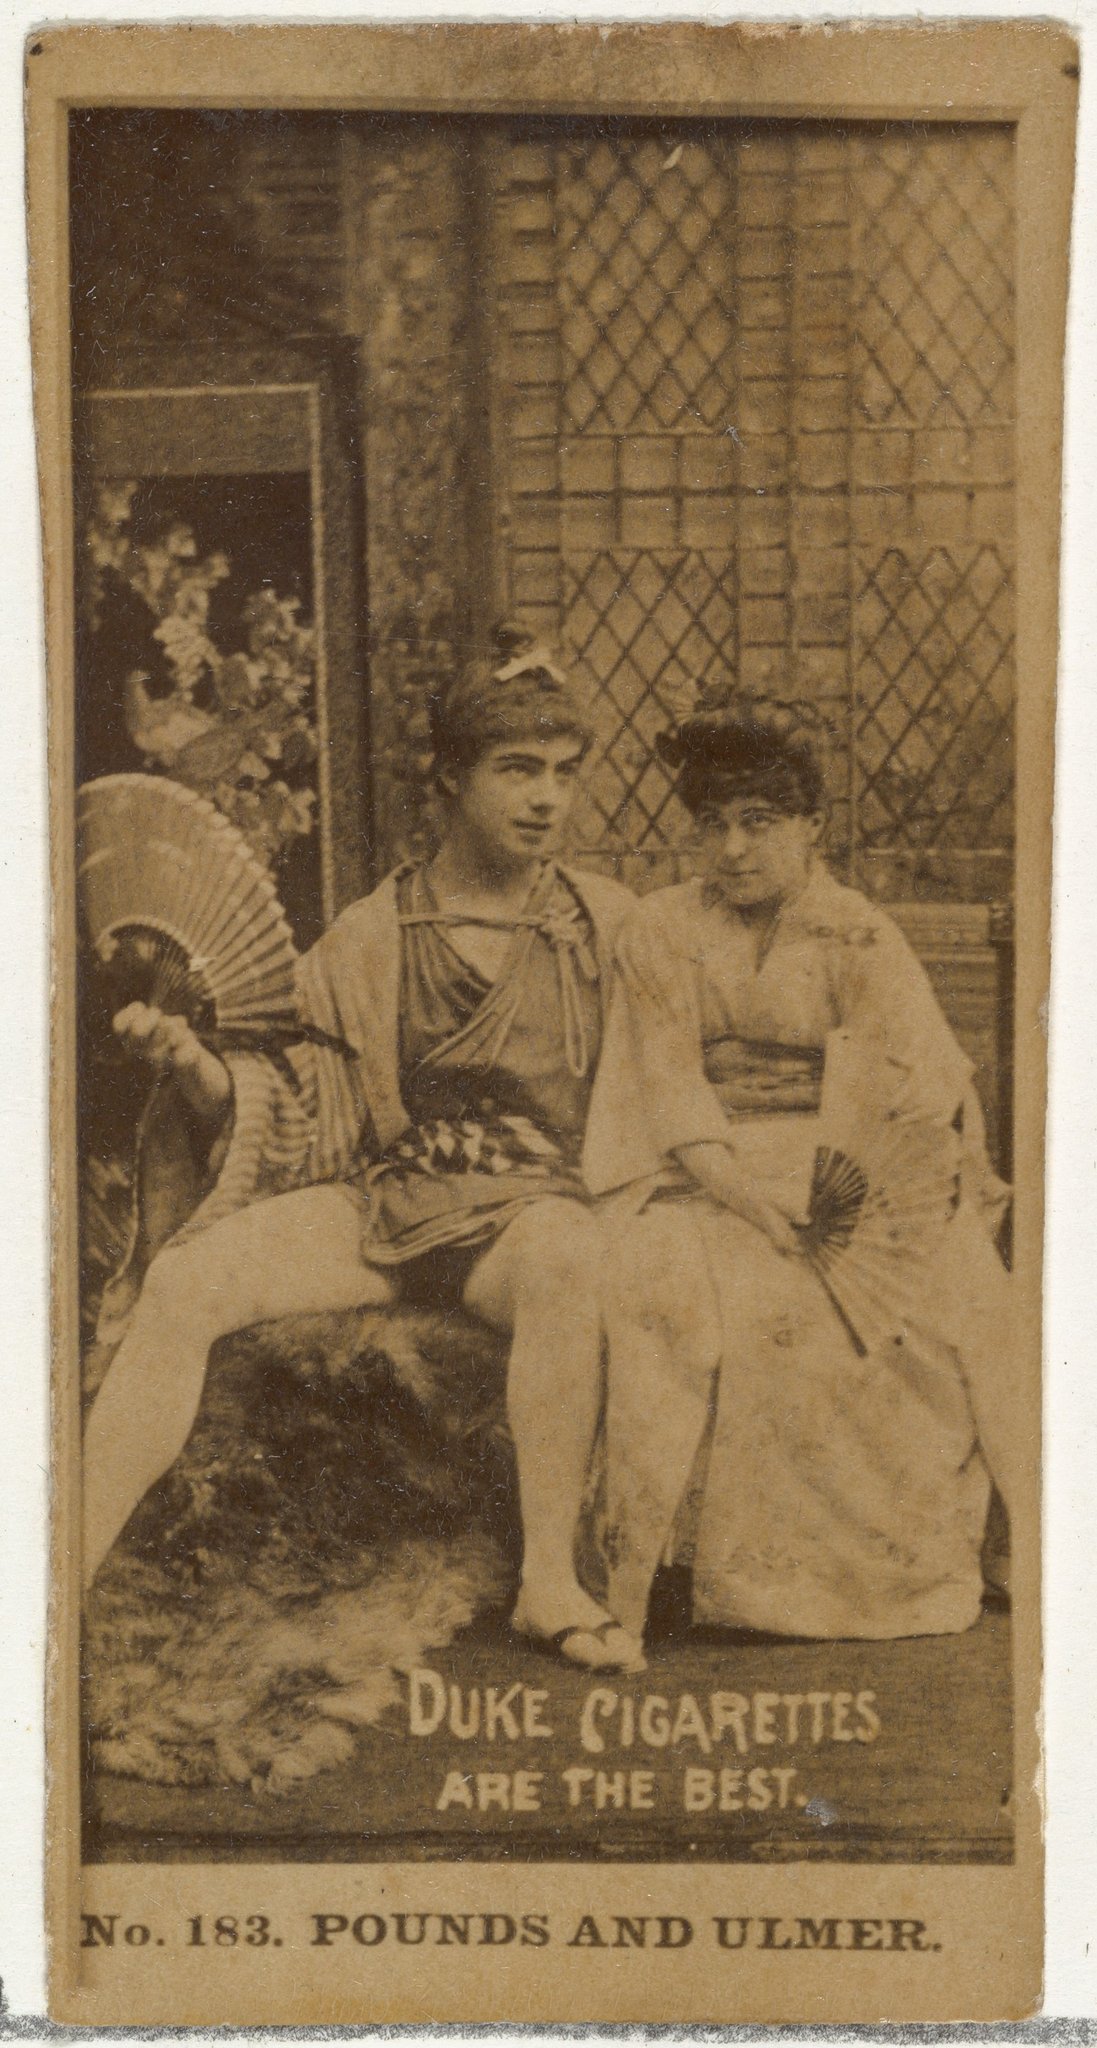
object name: photograph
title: Card Number 183, Pounds and Ulmer, from the Actors and Actresses series (N145-6) issued by Duke Sons & Co. to promote Duke Cigarettes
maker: w. duke, sons & co.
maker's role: publisher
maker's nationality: american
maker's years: 1870-1920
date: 1880-1889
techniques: albumen silver print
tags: portraits,women,actresses